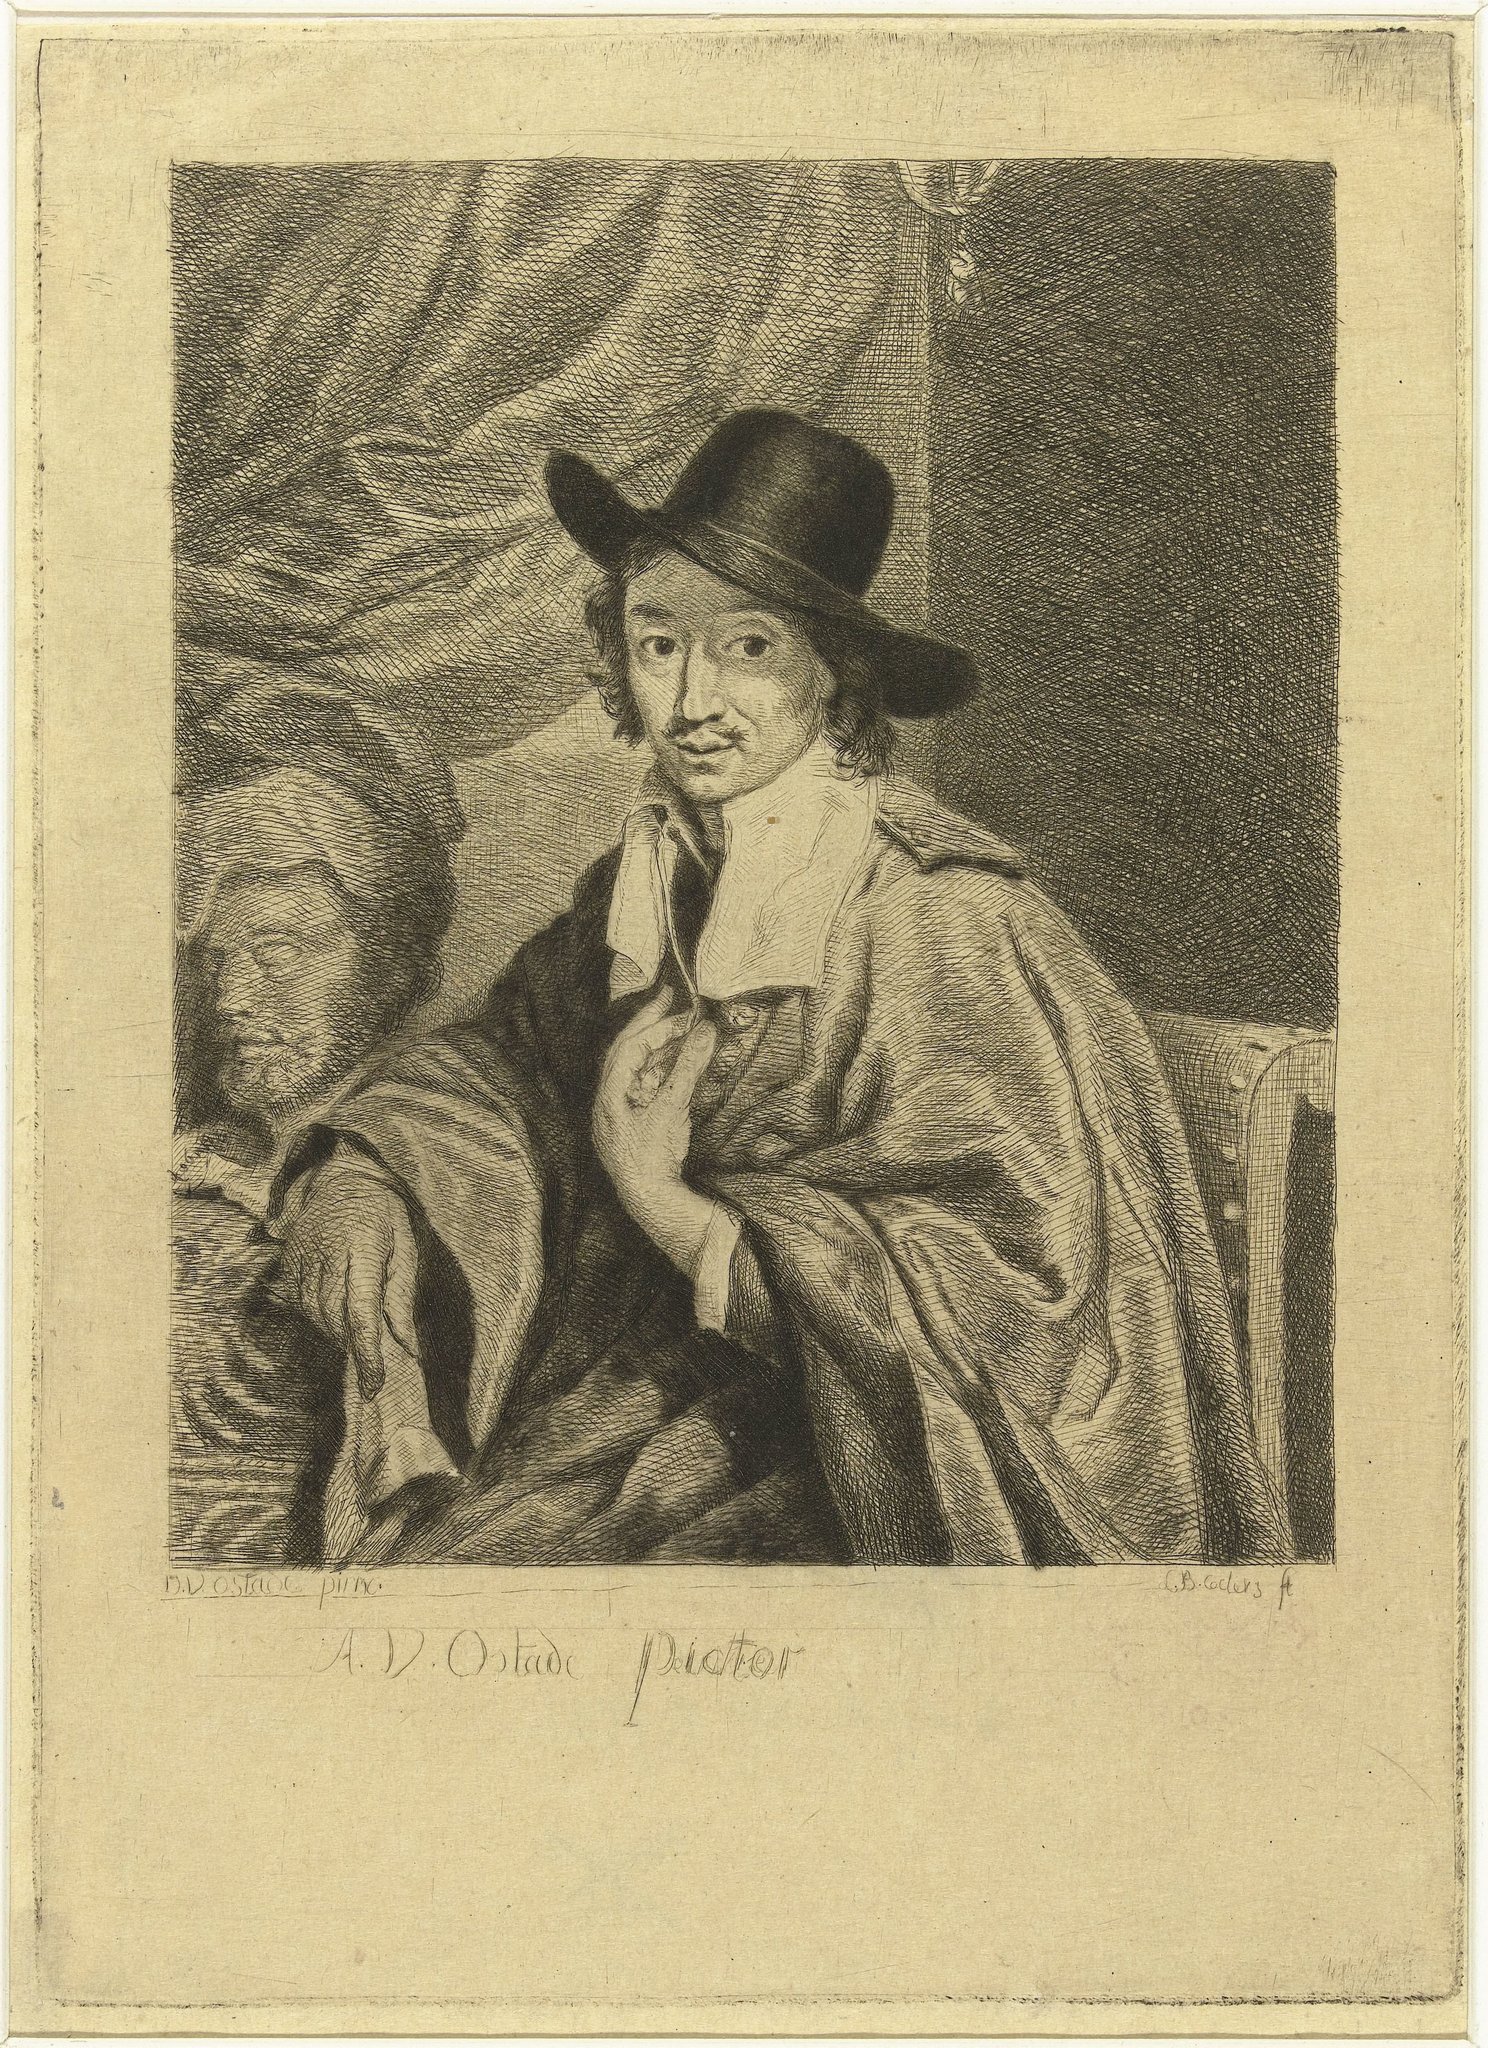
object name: print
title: Portret van de schilder Adriaen van Ostade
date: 1756-1817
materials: paper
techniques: drypoint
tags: haarlem, painter, print maker, draughtsman, adriaen van ostade, portrait, self-portrait of artist (+ artist in non-work situation)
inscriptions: collector's mark: Lugt 240